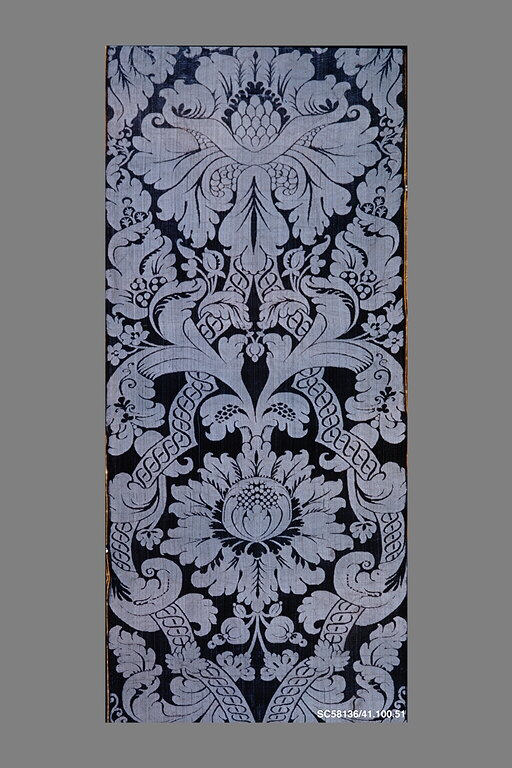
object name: panel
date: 1701-1733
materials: silk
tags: flowers